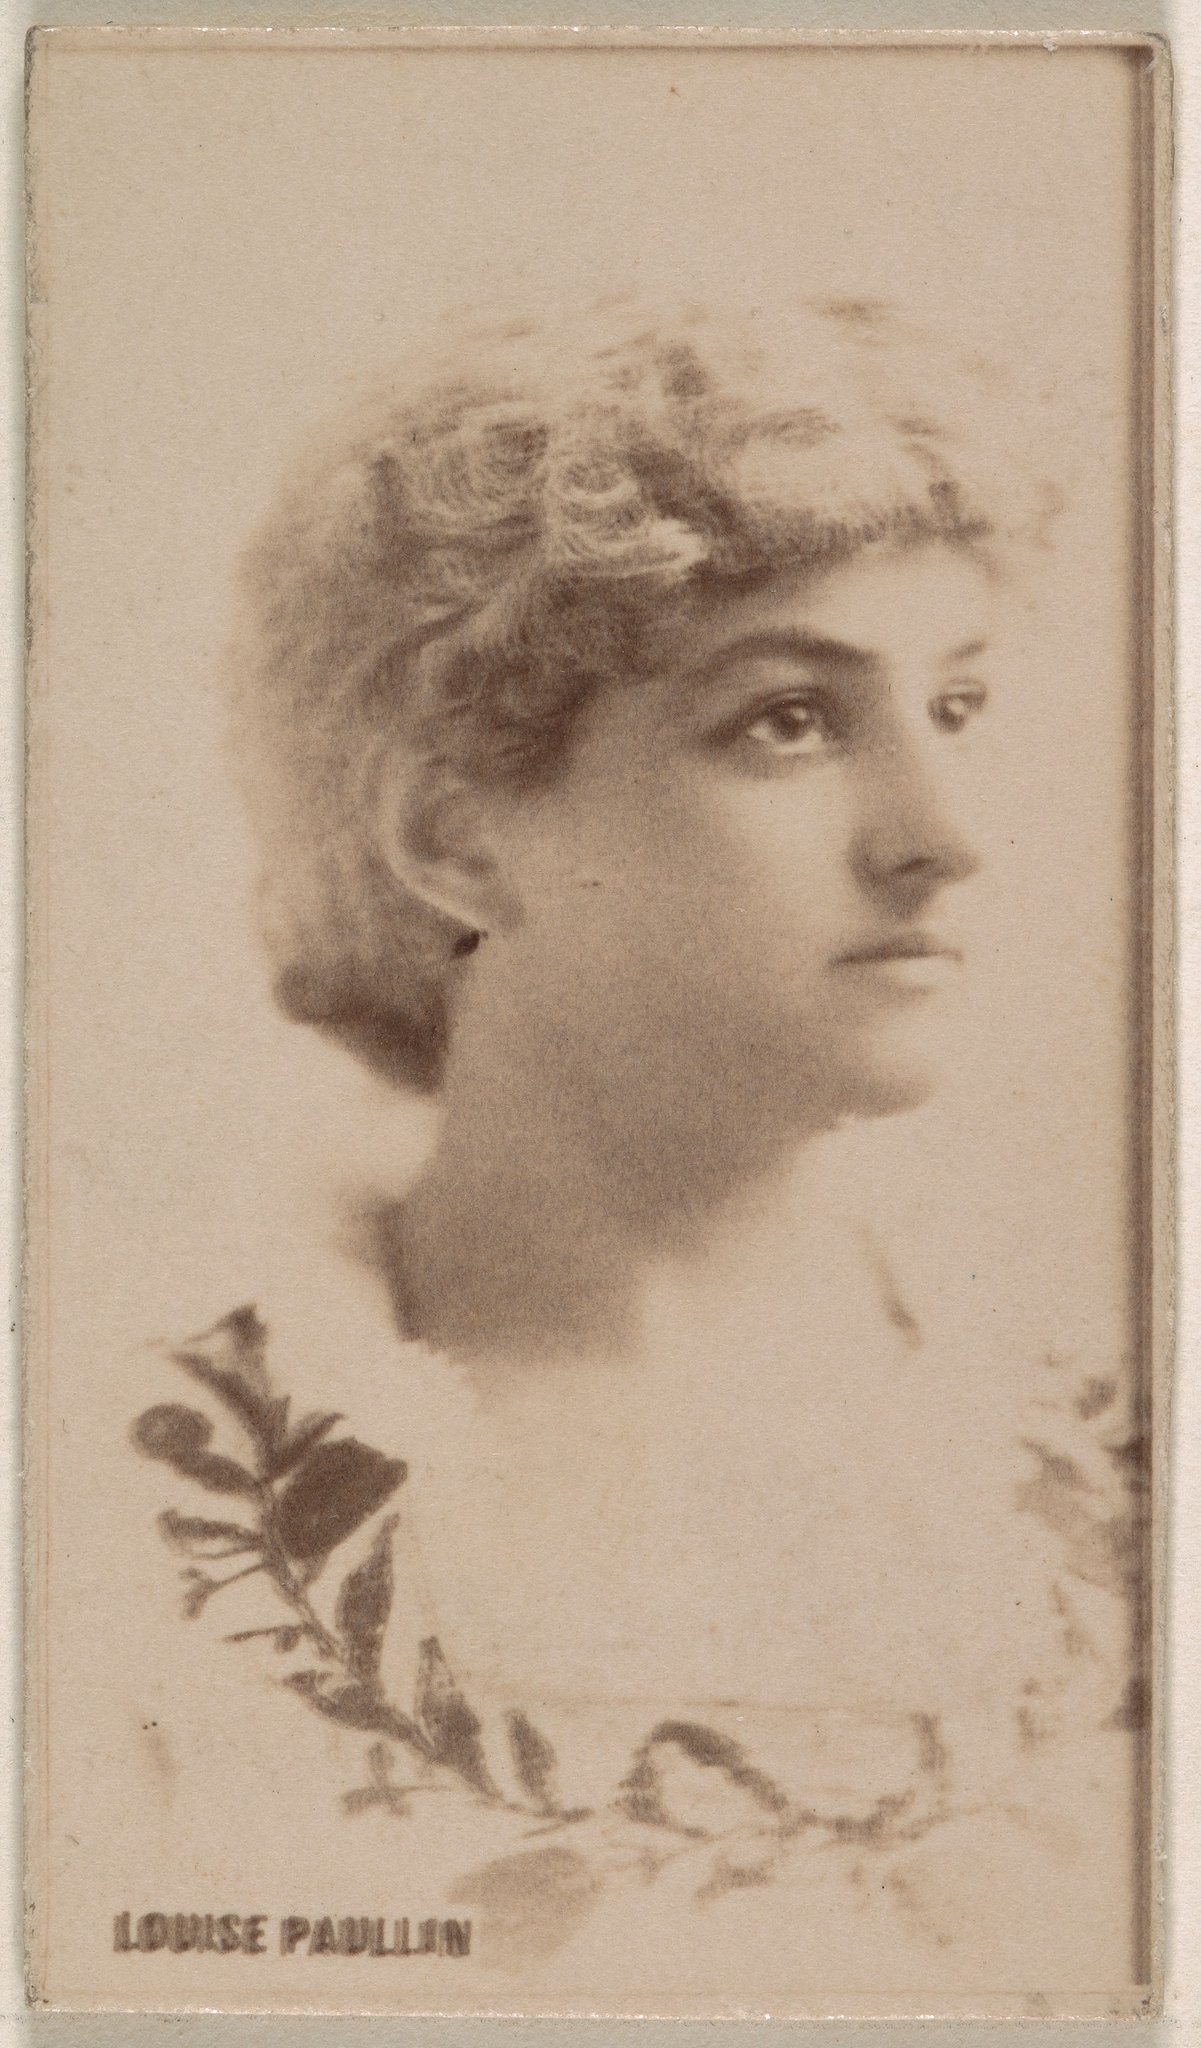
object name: photograph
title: Louise Paullin, from the Actresses series (N245) issued by Kinney Brothers to promote Sweet Caporal Cigarettes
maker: kinney brothers tobacco company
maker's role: publisher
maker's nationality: american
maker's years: 1869-2011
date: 1890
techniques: albumen silver print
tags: portraits,women,actresses